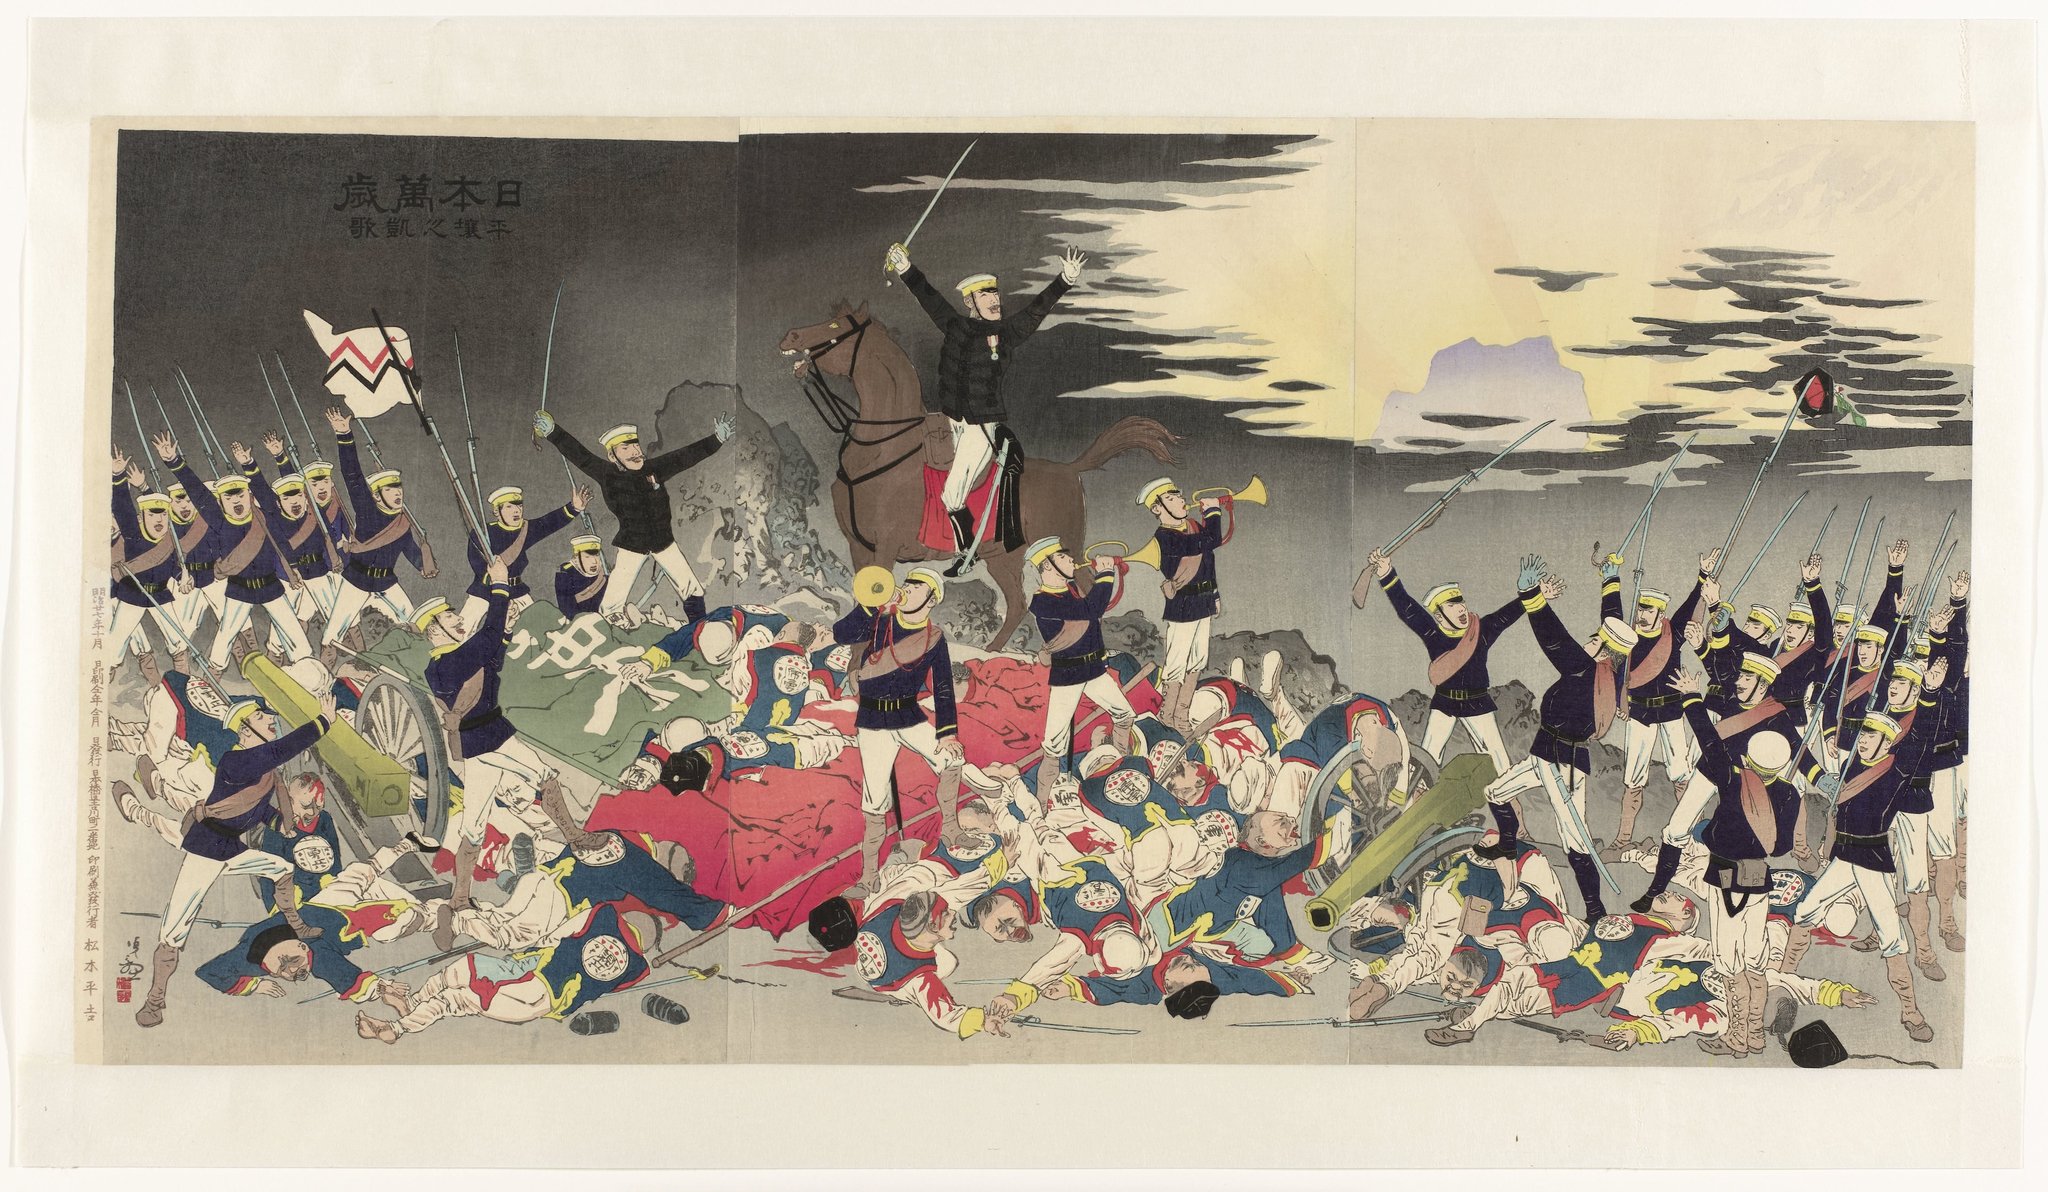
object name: print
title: Nippon banzai, Heijô no gaika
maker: kobayashi kiyochika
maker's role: print maker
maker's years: 1847-1915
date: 1894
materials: paper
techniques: woodcut, polish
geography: japan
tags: military celebrations, victory ~ armed conflict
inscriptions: label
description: Japanse soldaten zegevieren hun overwinning in Pyongyang, staand op de lijken van Koreaanse soldaten. Op 16 september 1894 gaf de stad zich over aan het Japanse leger, dit gebeurde tijdens de Eerste Chinees-Japanse Oorlog (1894-1895).